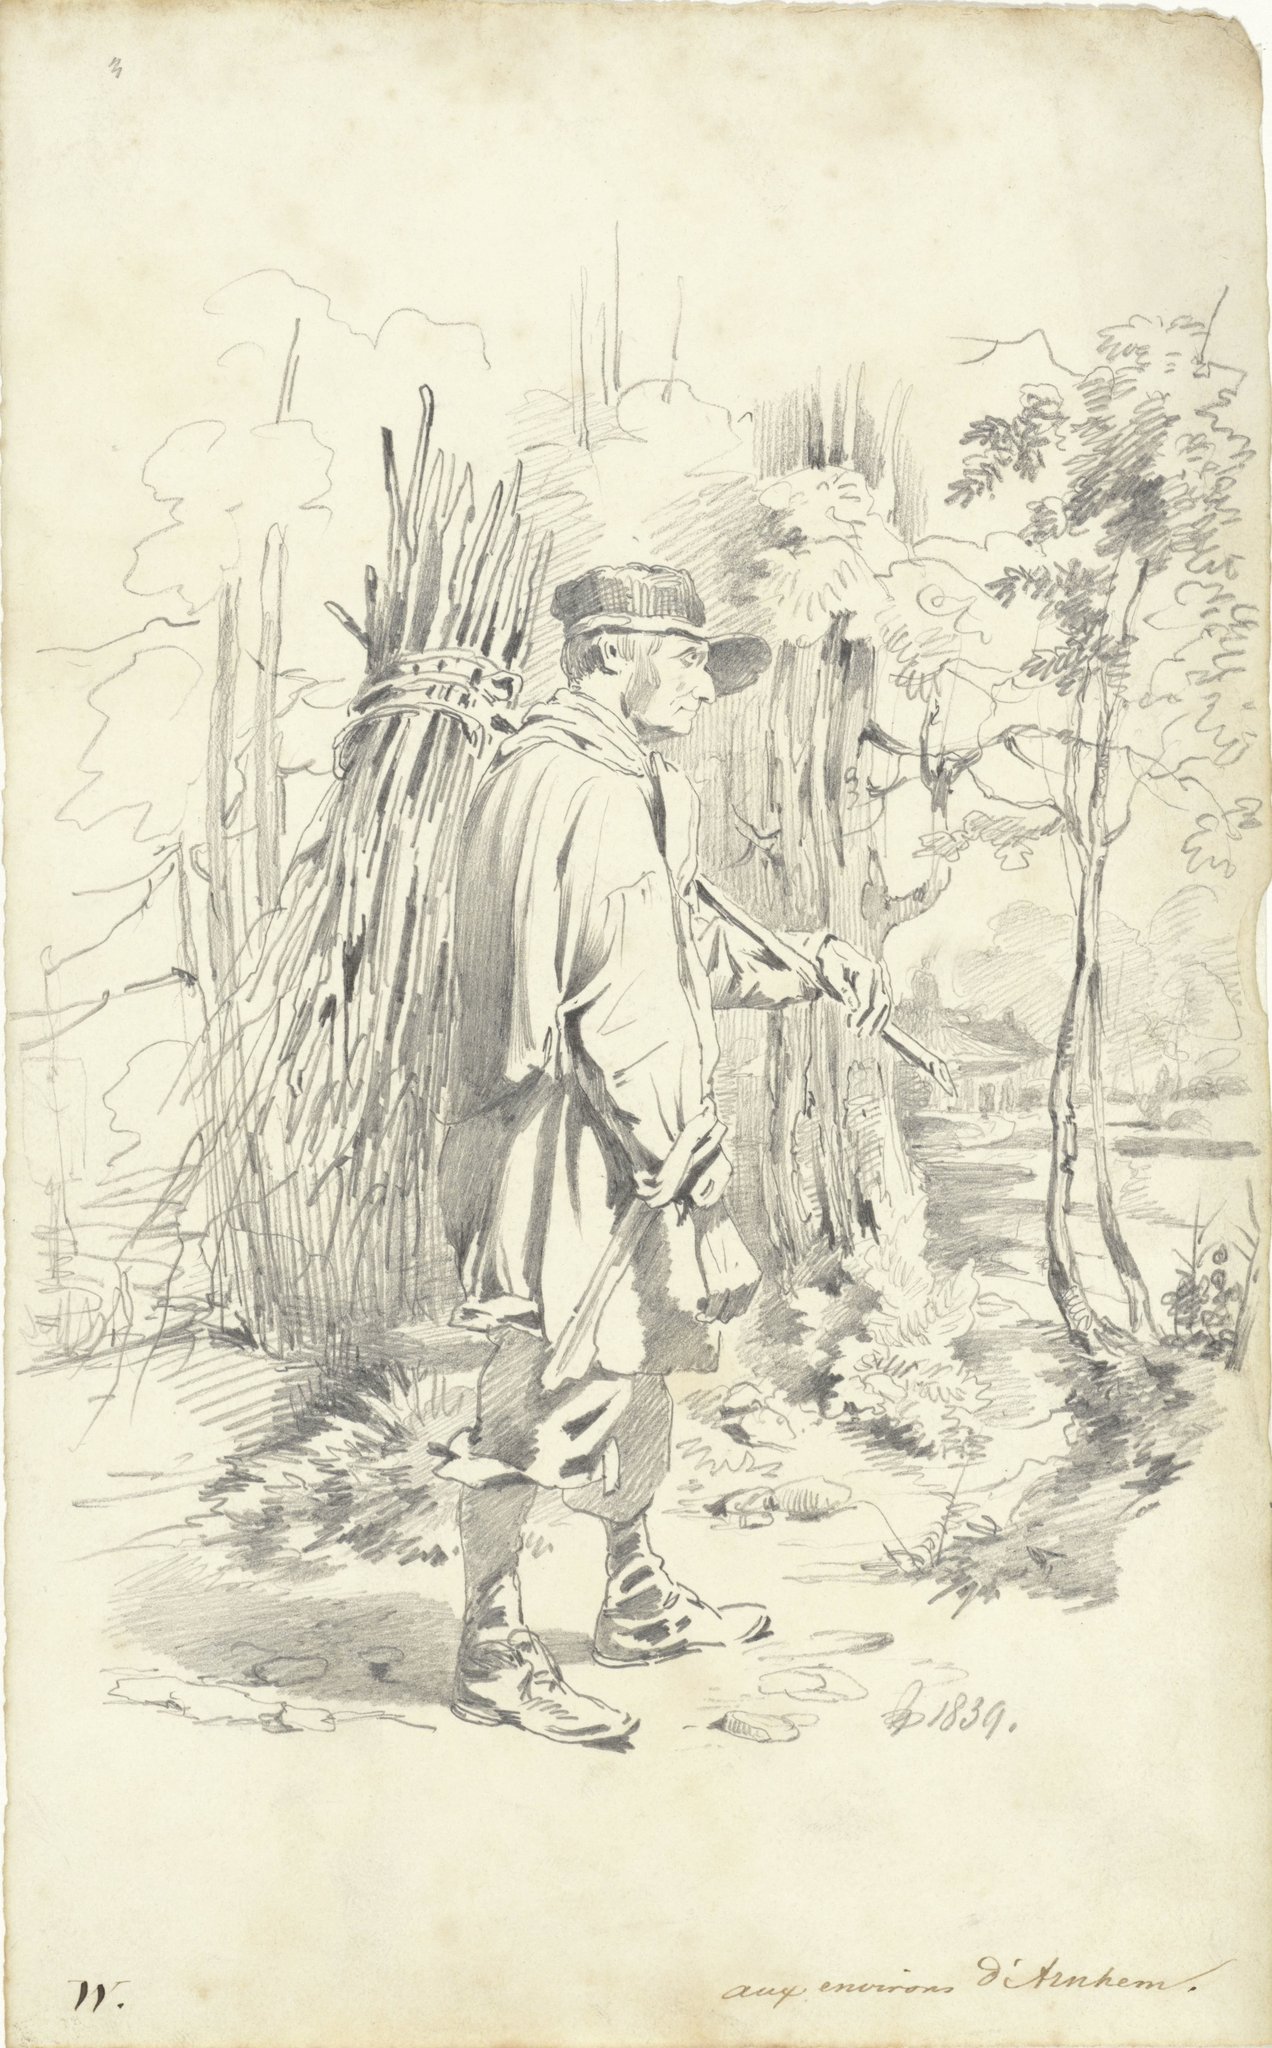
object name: drawing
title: Sprokkelaar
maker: pieter van loon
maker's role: draughtsman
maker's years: 1801-1873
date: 1839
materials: paper, pencil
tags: woodcutting, woodcutter ~ forestry, folk costume, regional costume, arnhem